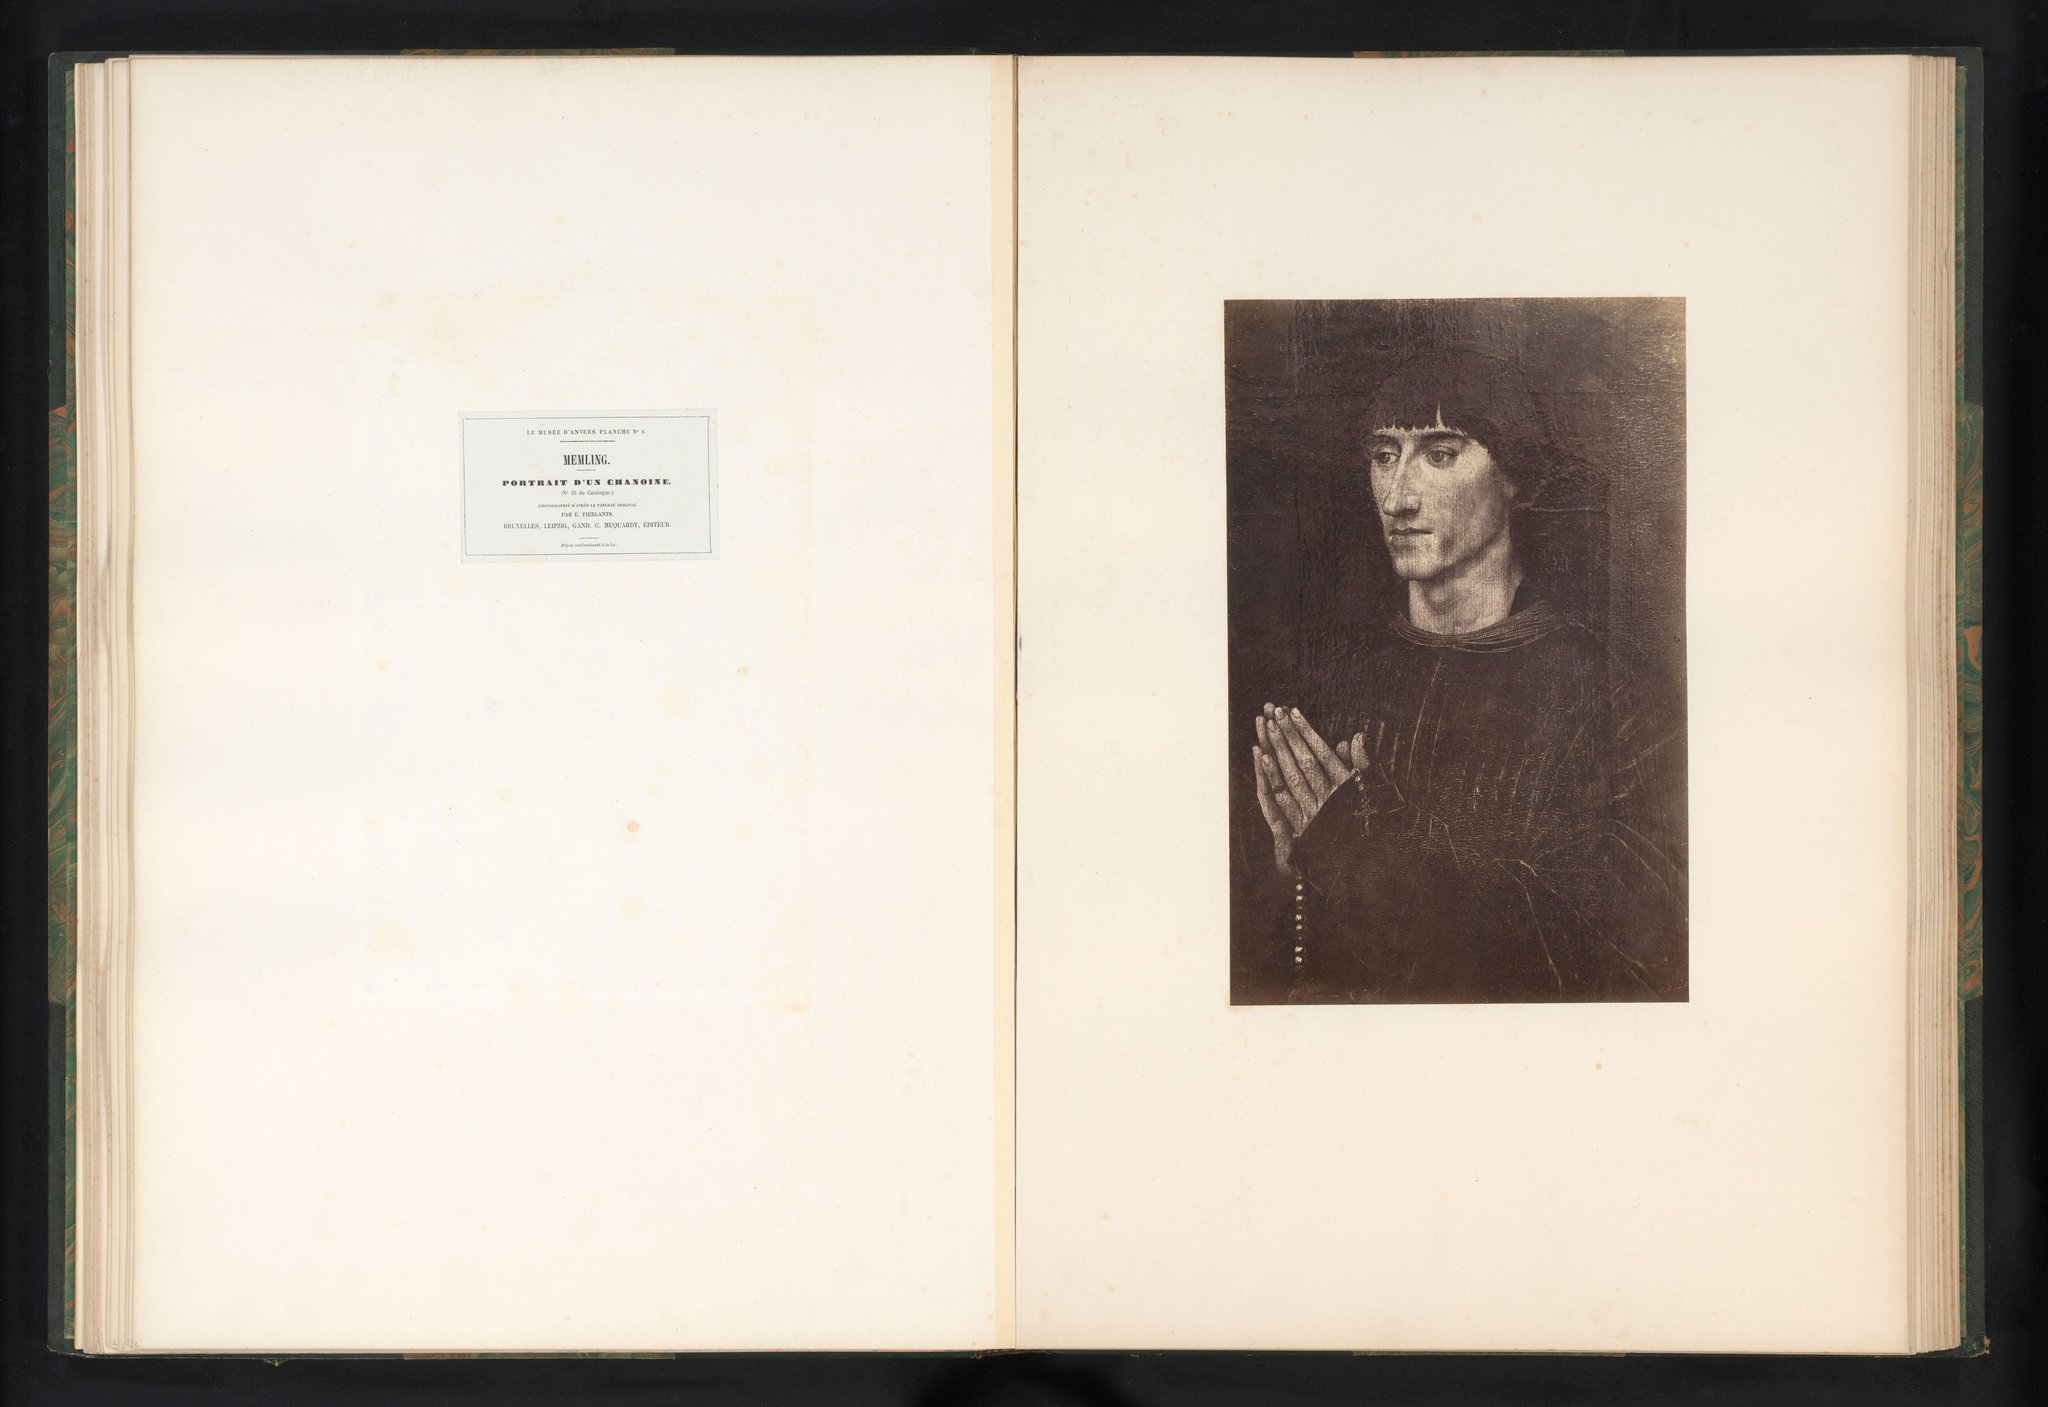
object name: page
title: Fotoreproductie van Philippe de Croy door Hans Memling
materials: photographic support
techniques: albumen print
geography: brussels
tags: historical persons